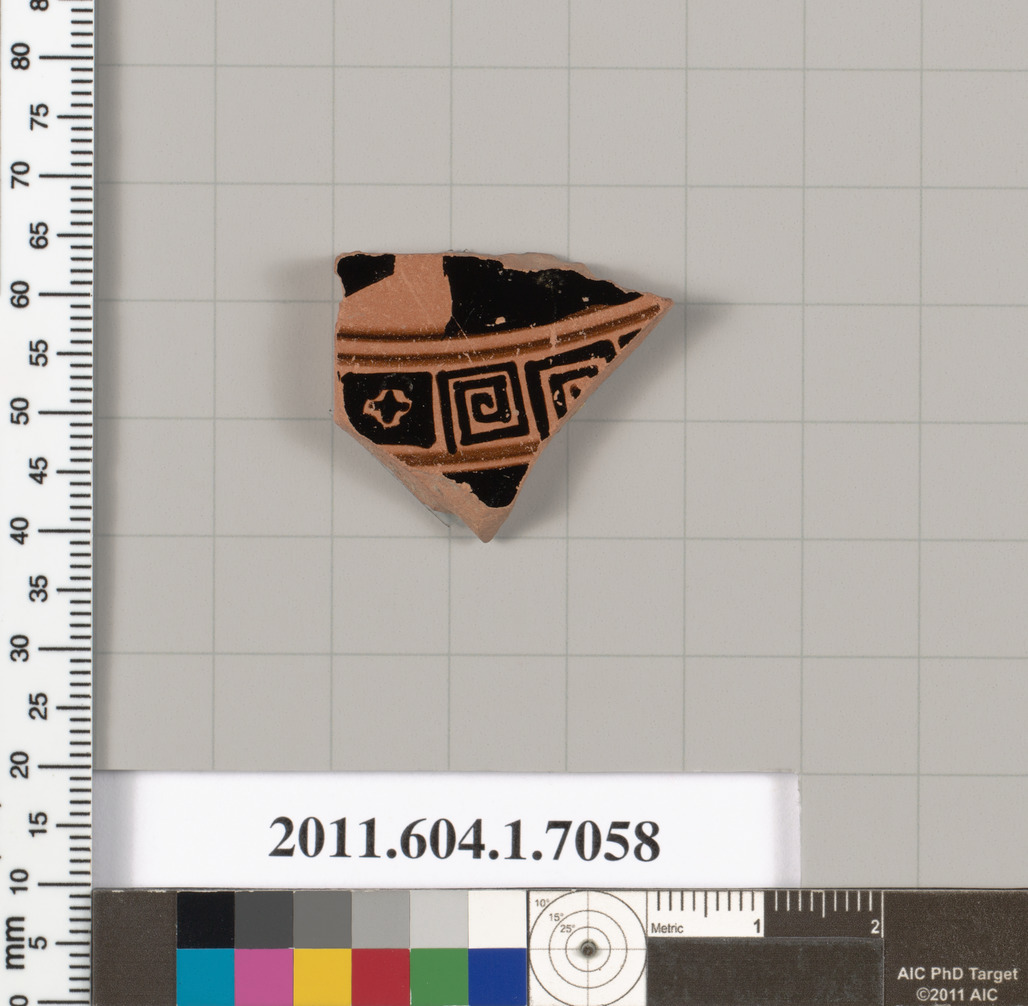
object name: kylix fragment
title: Terracotta fragment of a kylix (drinking cup)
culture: greek, attic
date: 500-480 BCE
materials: terracotta